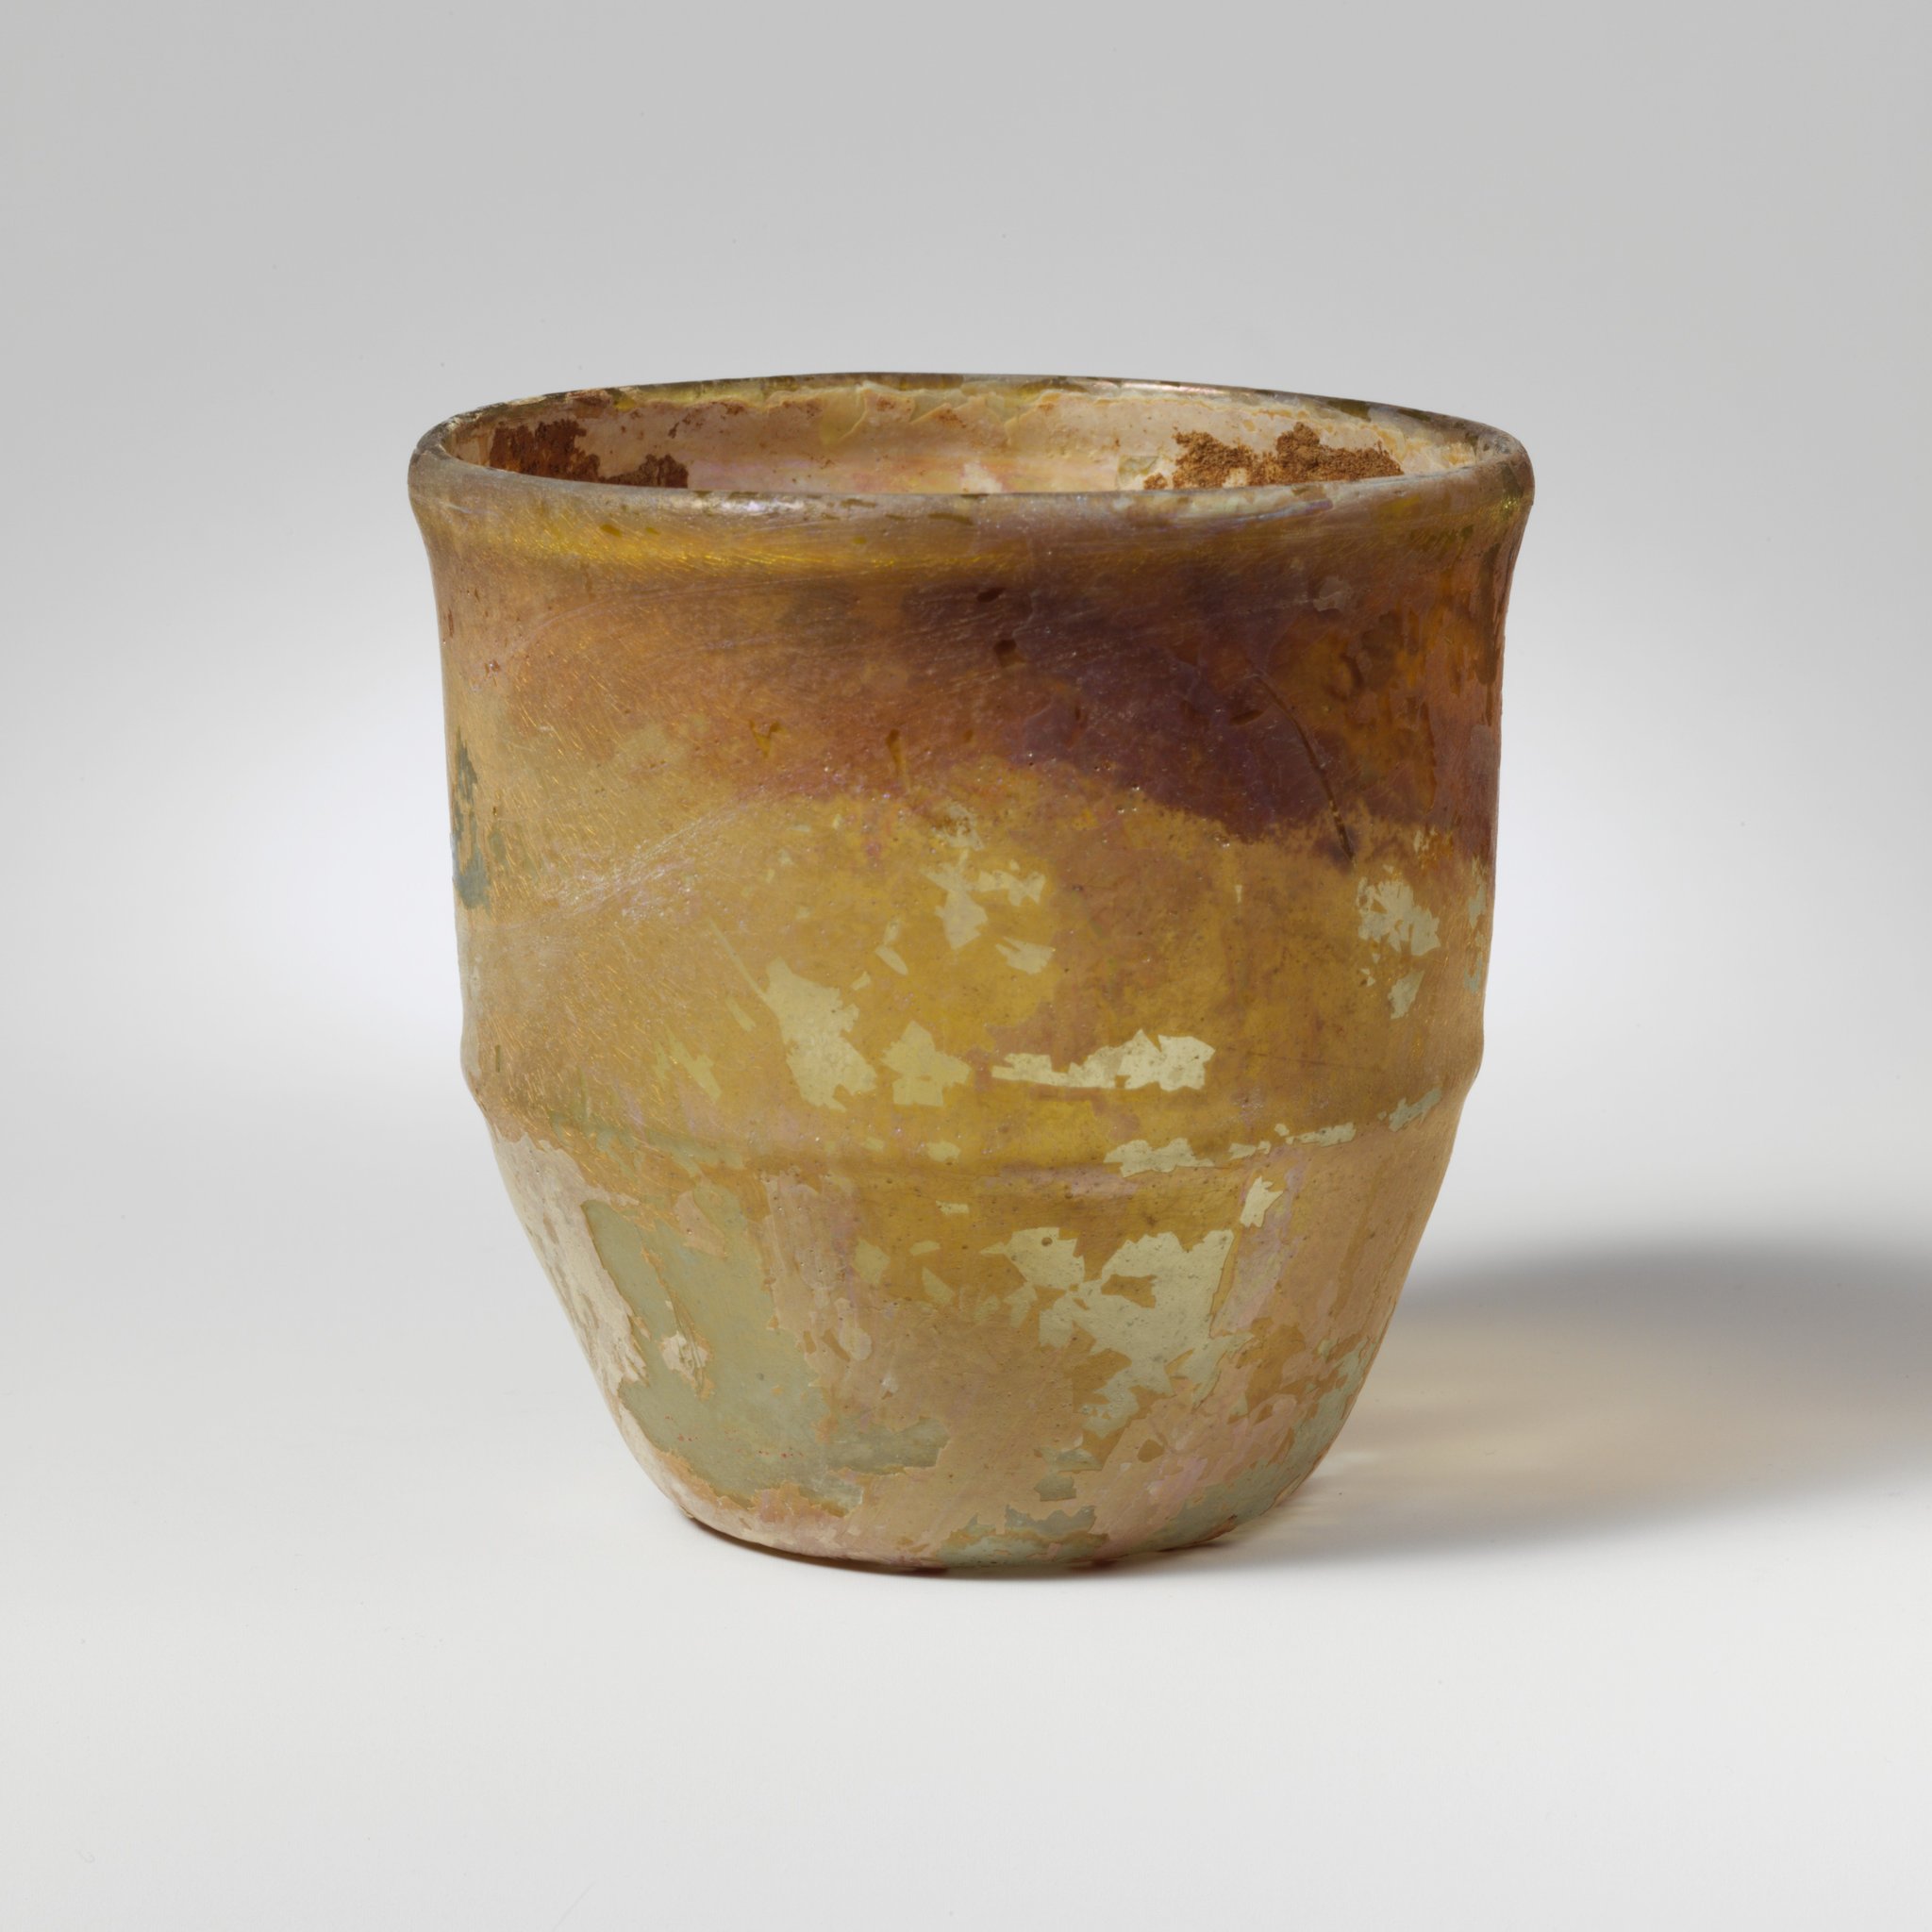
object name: cup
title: Glass cup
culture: roman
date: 101-300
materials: glass